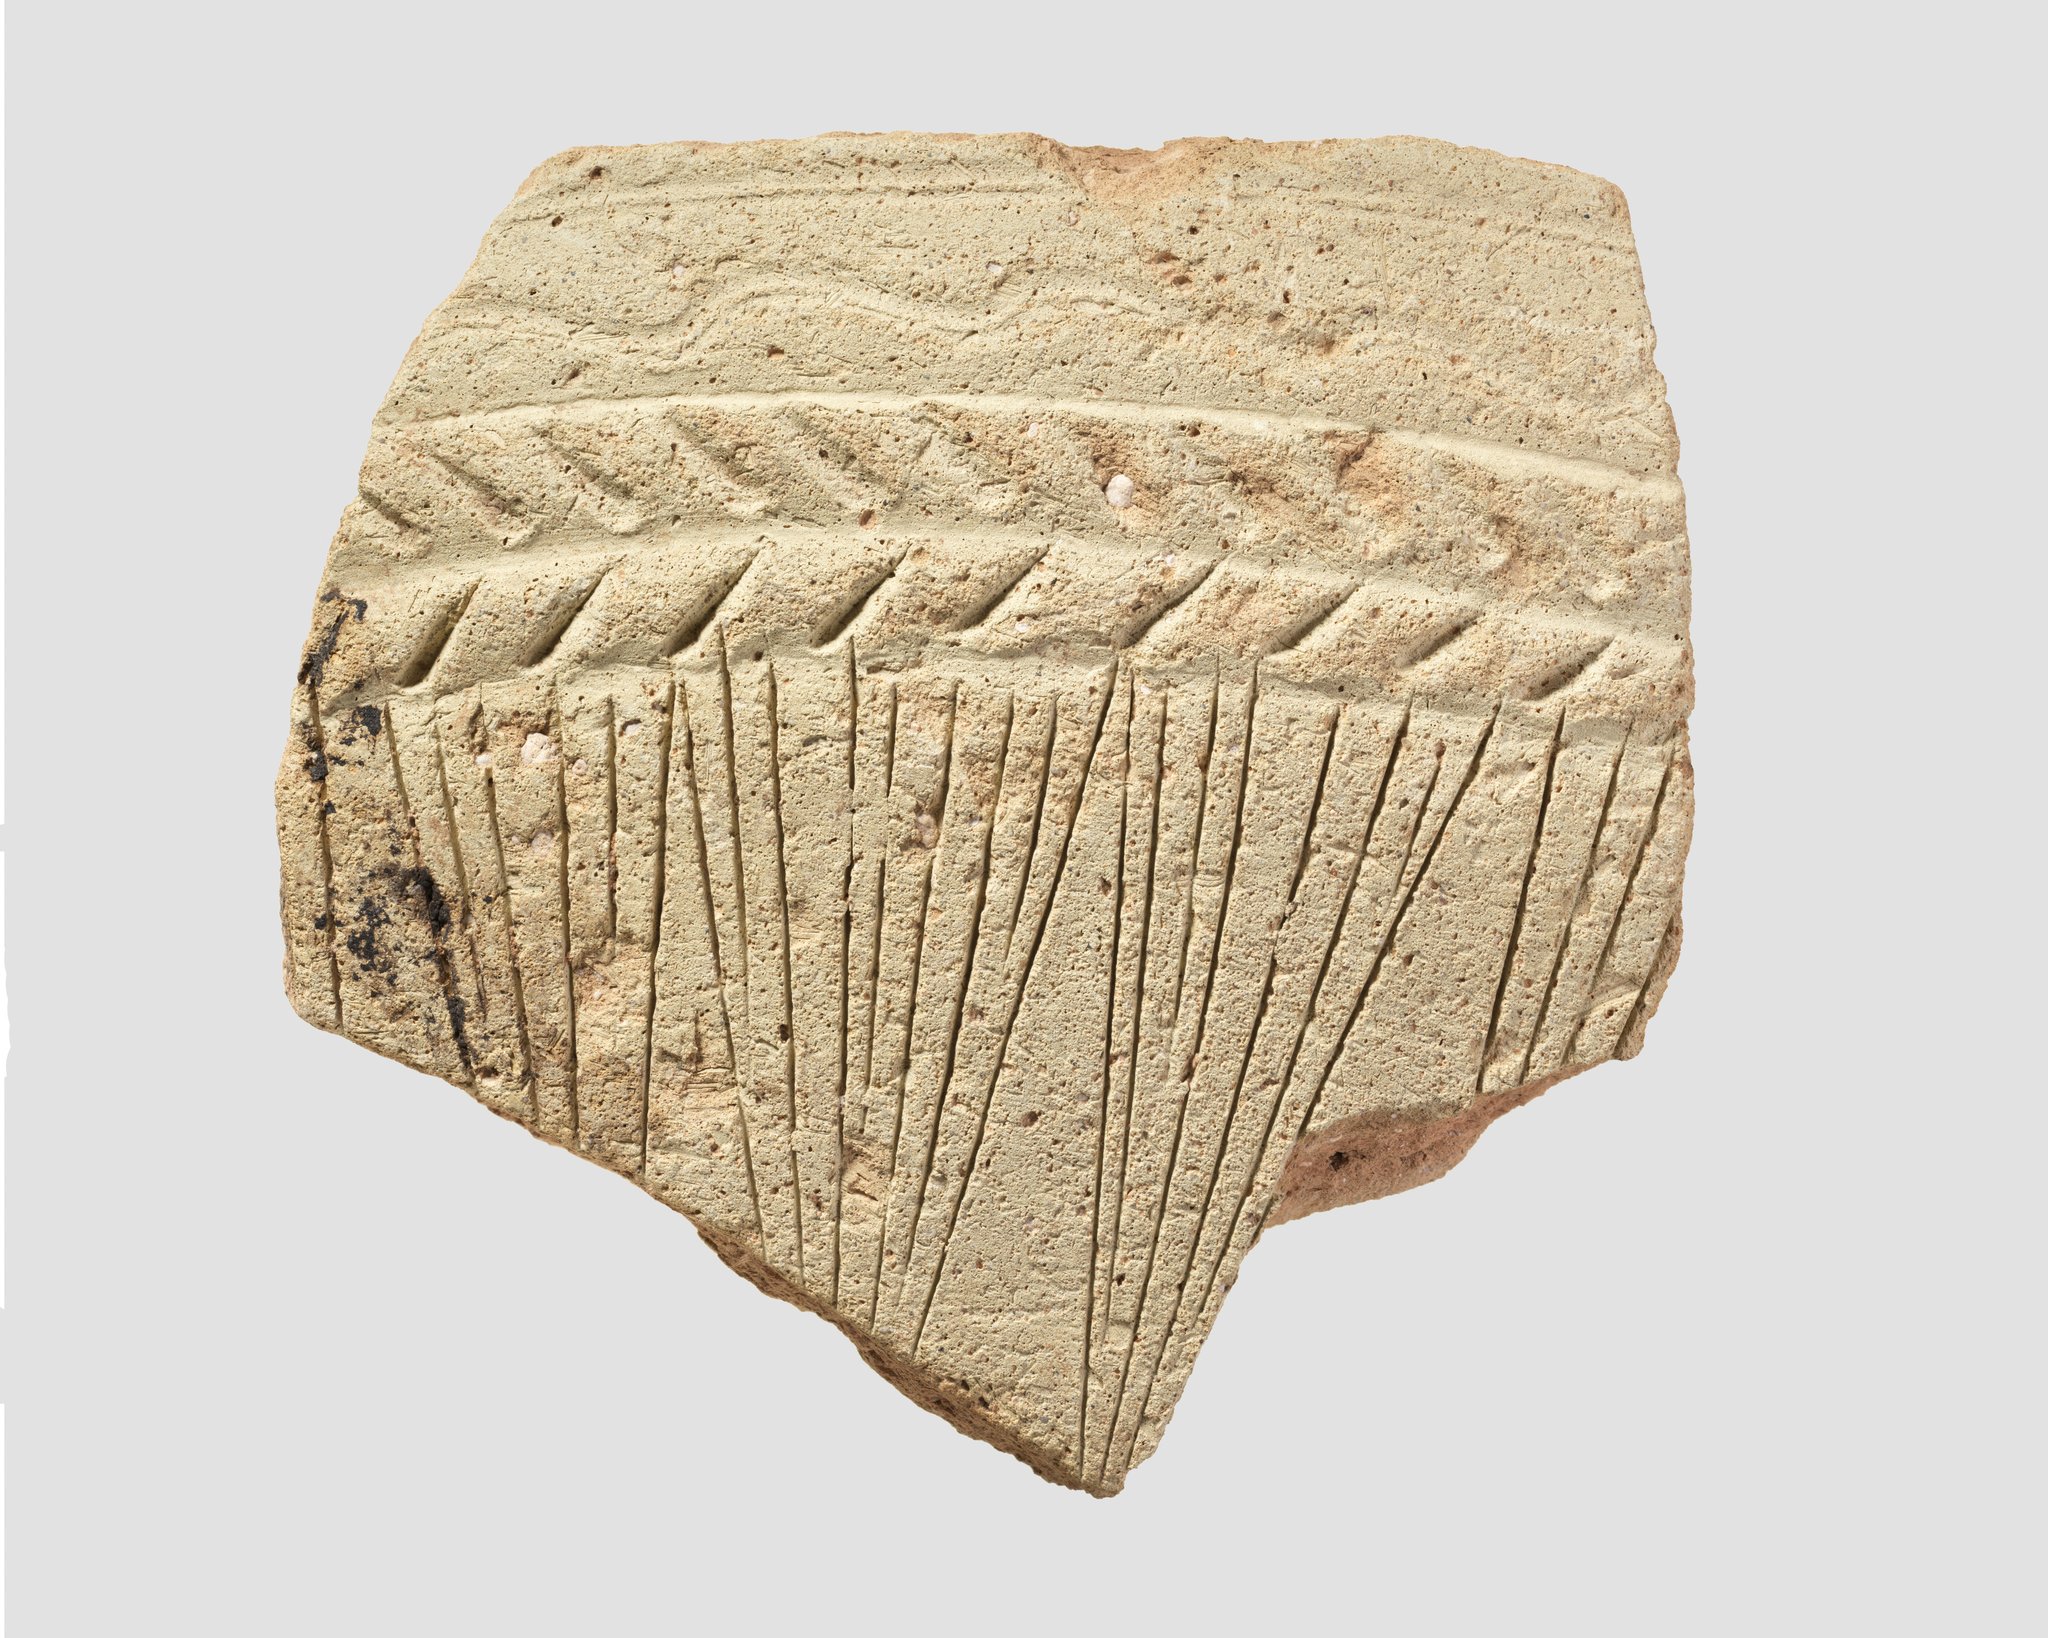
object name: sherd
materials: ceramic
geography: mesopotamia